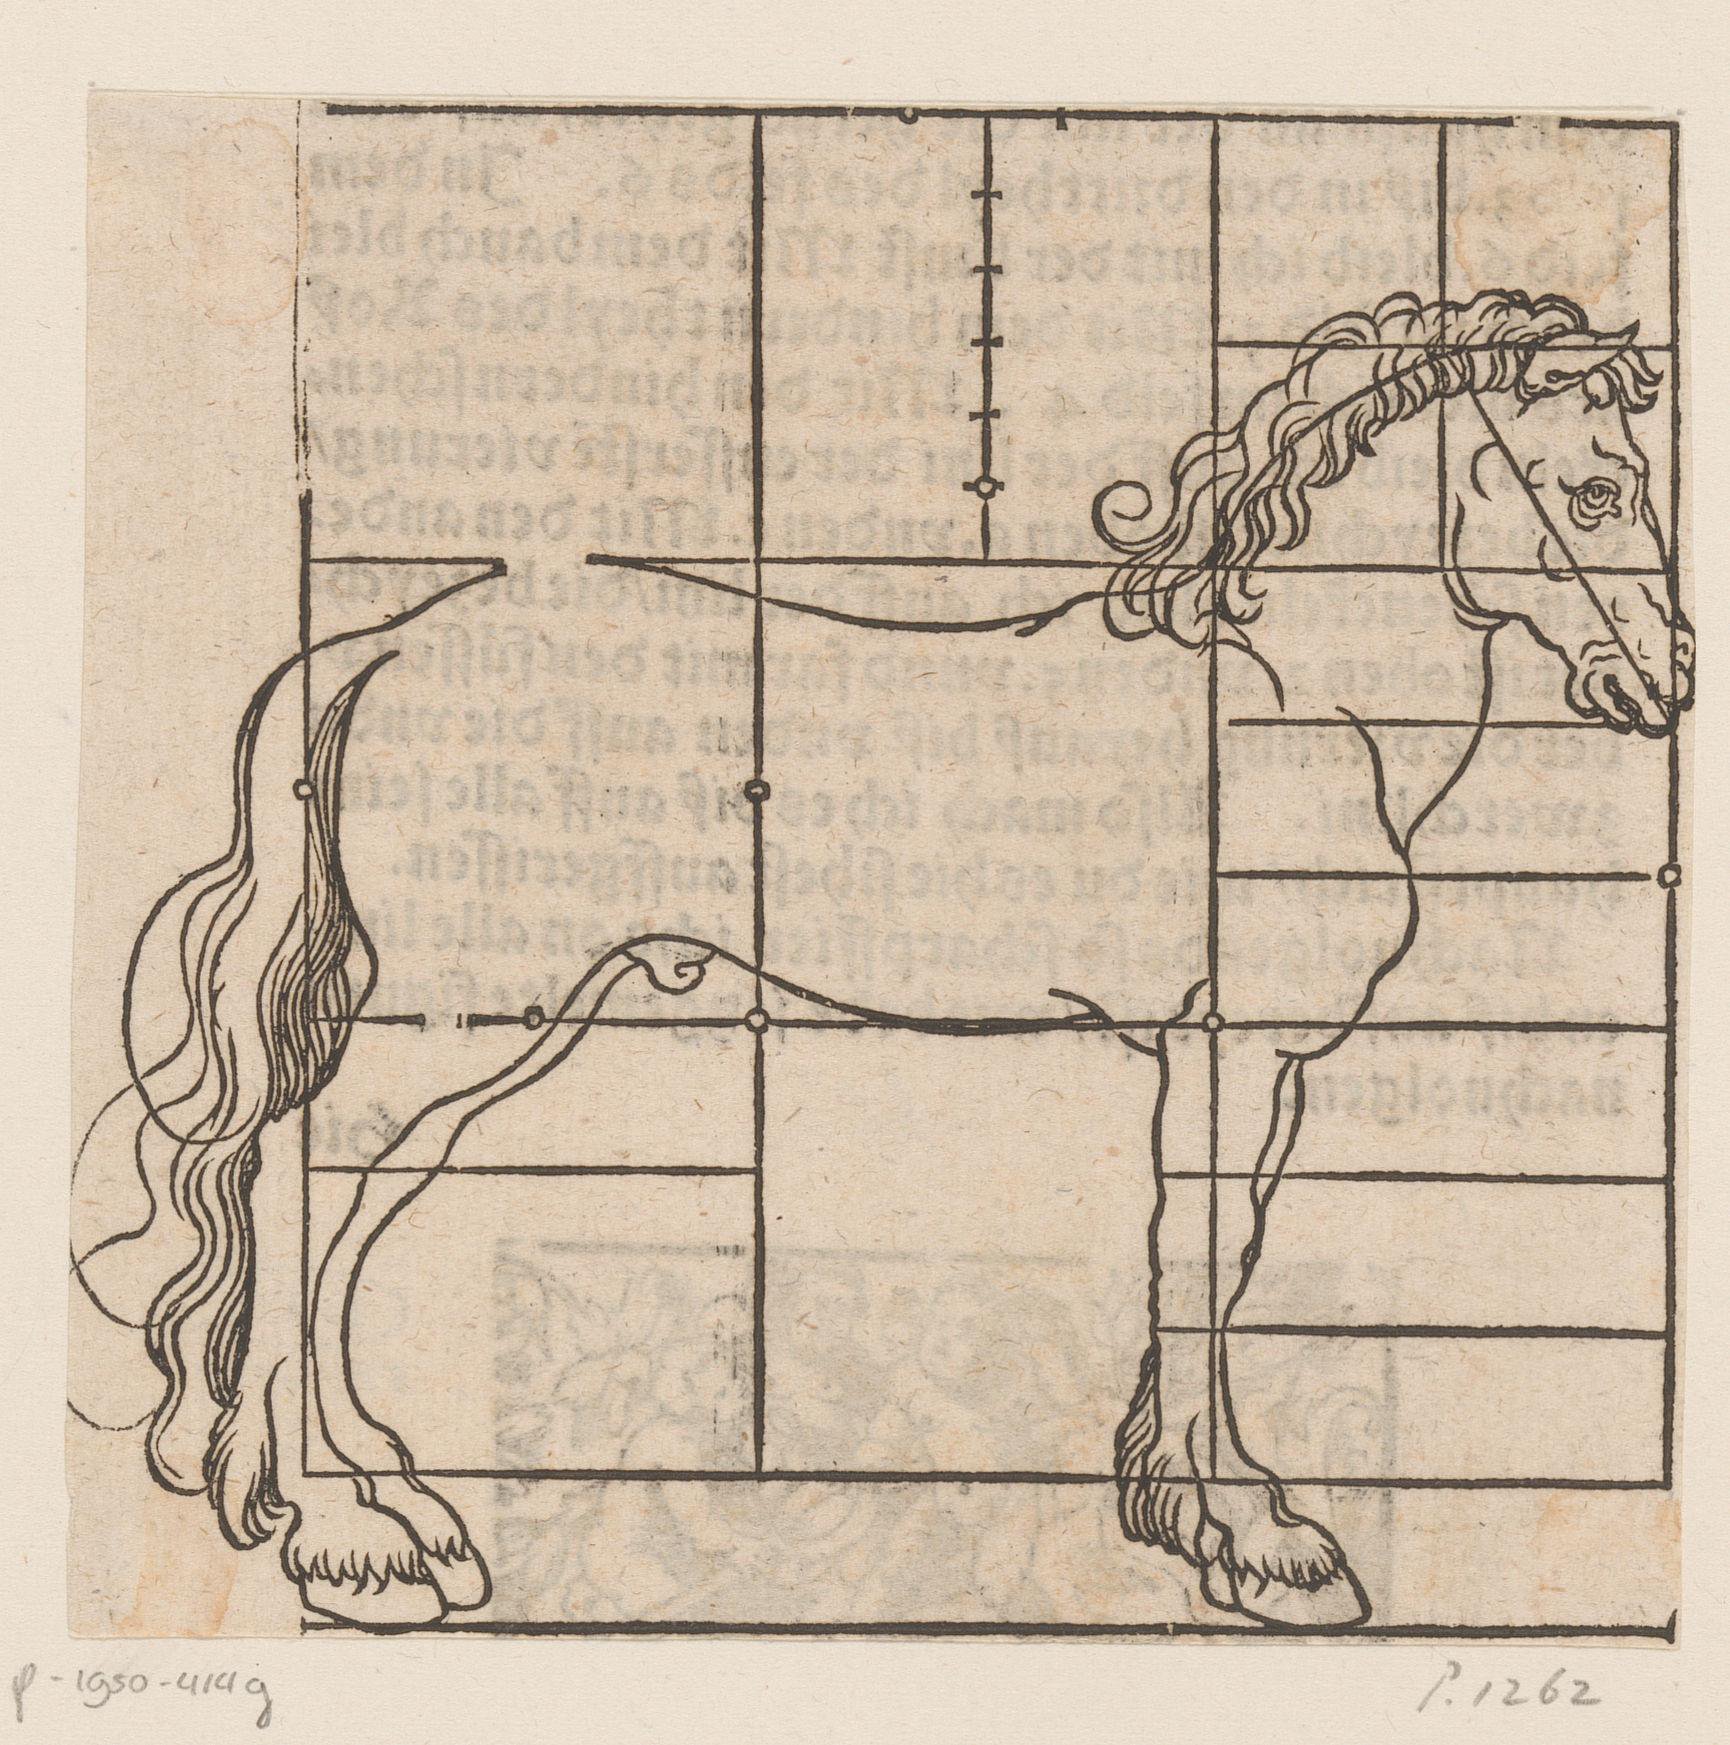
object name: print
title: Model voor een paard met raster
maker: Anonymous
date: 1565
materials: paper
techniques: letterpress printing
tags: horses and kindred animals, model-books ~ implements of painter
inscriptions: collector's mark: Lugt 2228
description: Prent afkomstig uit: Beham, Hans Sebald. Sebalden Behems Kunst und Ler Büchlin (...). Frankfurt am Main: erven Christian Egenolff, 1565.